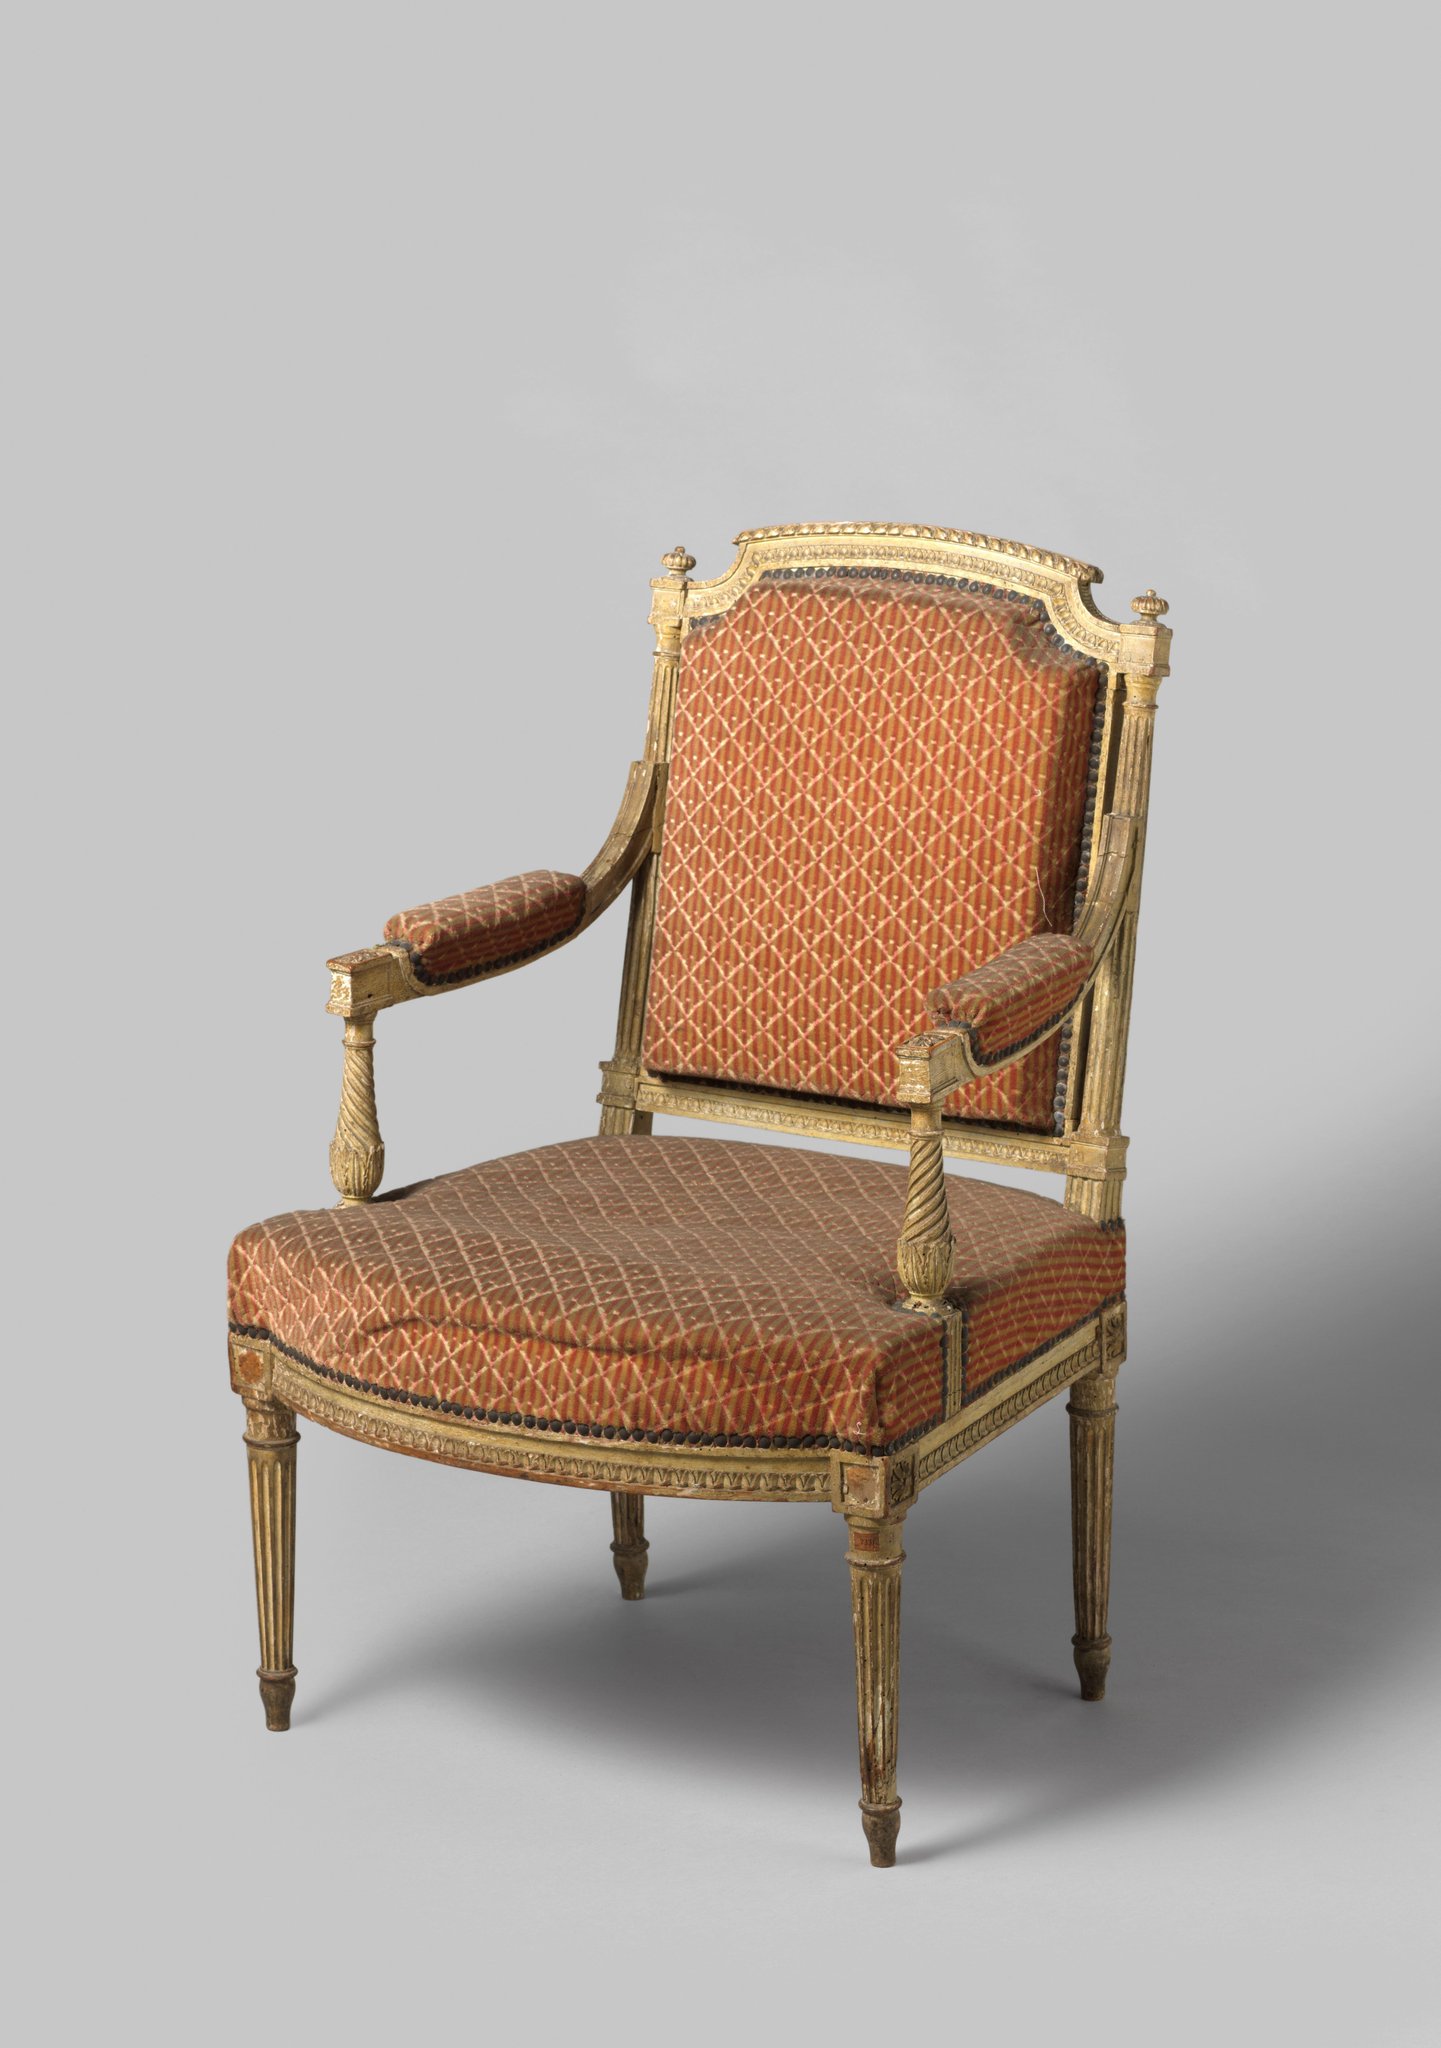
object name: armchair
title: Armstoel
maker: Anonymous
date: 1775-1800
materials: wood, paint, textile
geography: france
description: Armstoel, bekleed, van witgeschilderd beukenhout en rustend op conische poten met cannelures. De zitregels dragen een schubversiering. De vaasvormige armleggerstutten, met geslingerde cannelures en bladversiering onderaan, steunen de armleggers die eindigen in vierkanten met cannelures en rozetten bovenop. Zij lopen omhoog naar de stijlen van het rugraam, in de vorm van vrijstaande gecanneleerde Toscaanse colonnetten bekroond met vaasjes. De lichtgebogen bovendorpel heeft uitgeronde hoeken; boog met knorren.